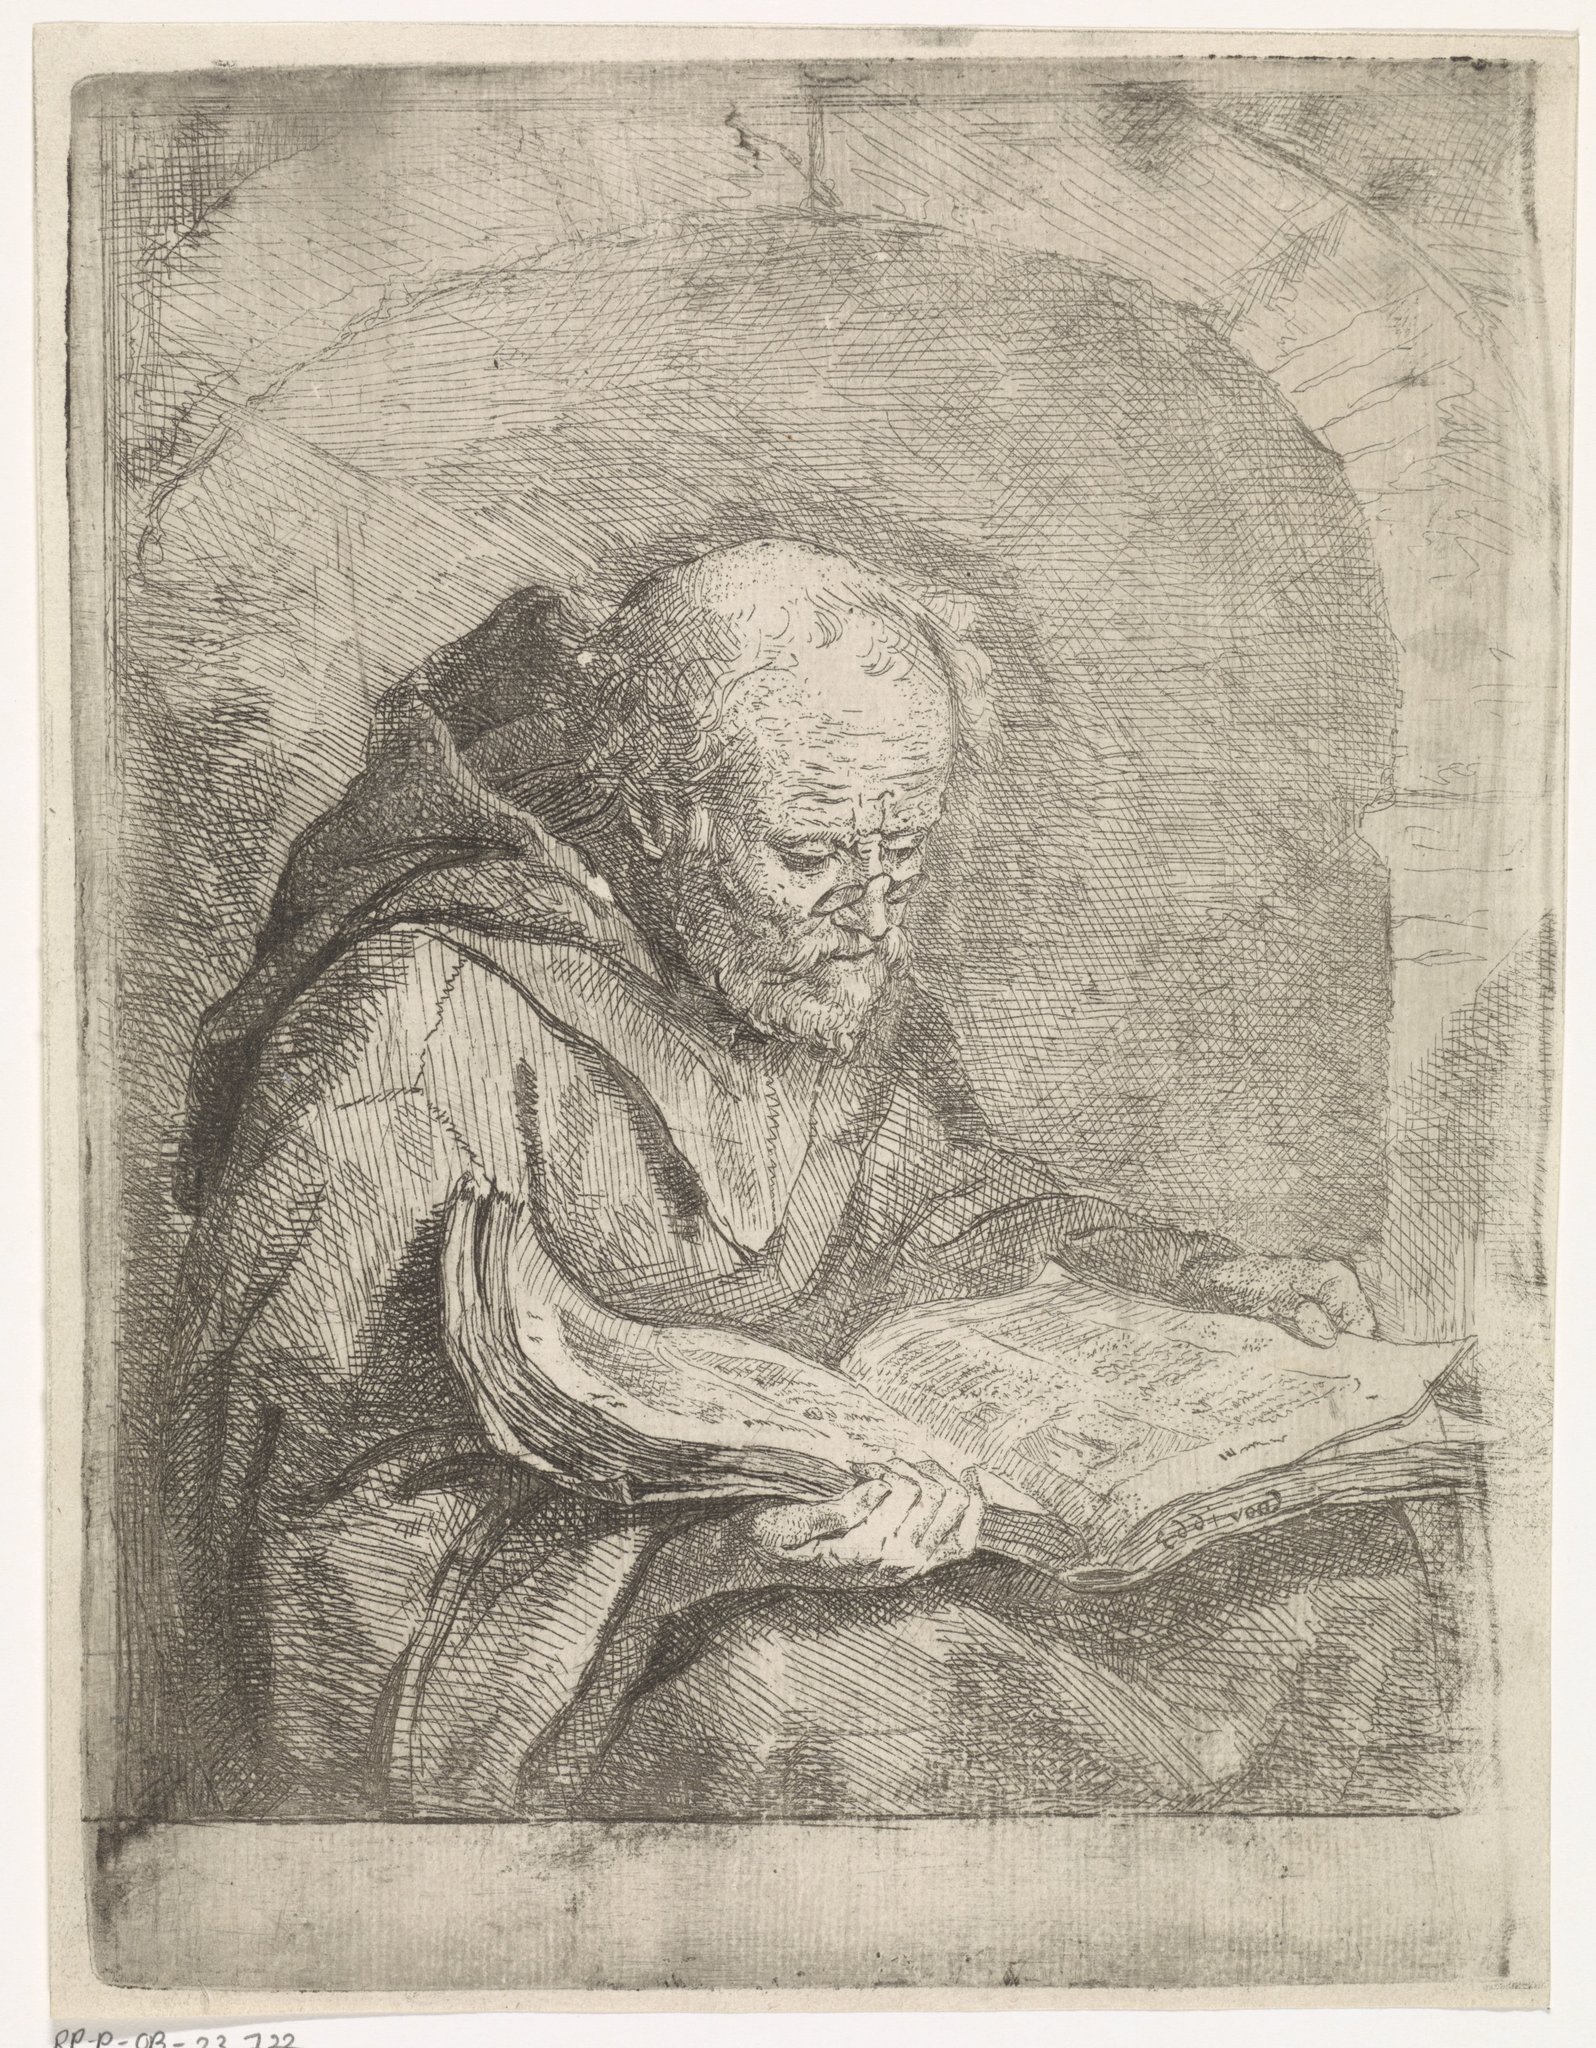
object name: print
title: Lezende monnik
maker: carel de moor (ii)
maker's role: draughtsman, painter, print maker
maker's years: 1655-1738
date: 1665-1738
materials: paper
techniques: etching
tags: reading, monk(s), friar(s)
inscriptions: collector's mark: Lugt 240, inscription: ‘gekocht tot Leiden kost 10 st. van Carel de Moor geetst - is bijsonder fraie’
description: Een monnik, met een bril op zijn neus, leest het boek of de Bijbel, dat op zijn schoot ligt.